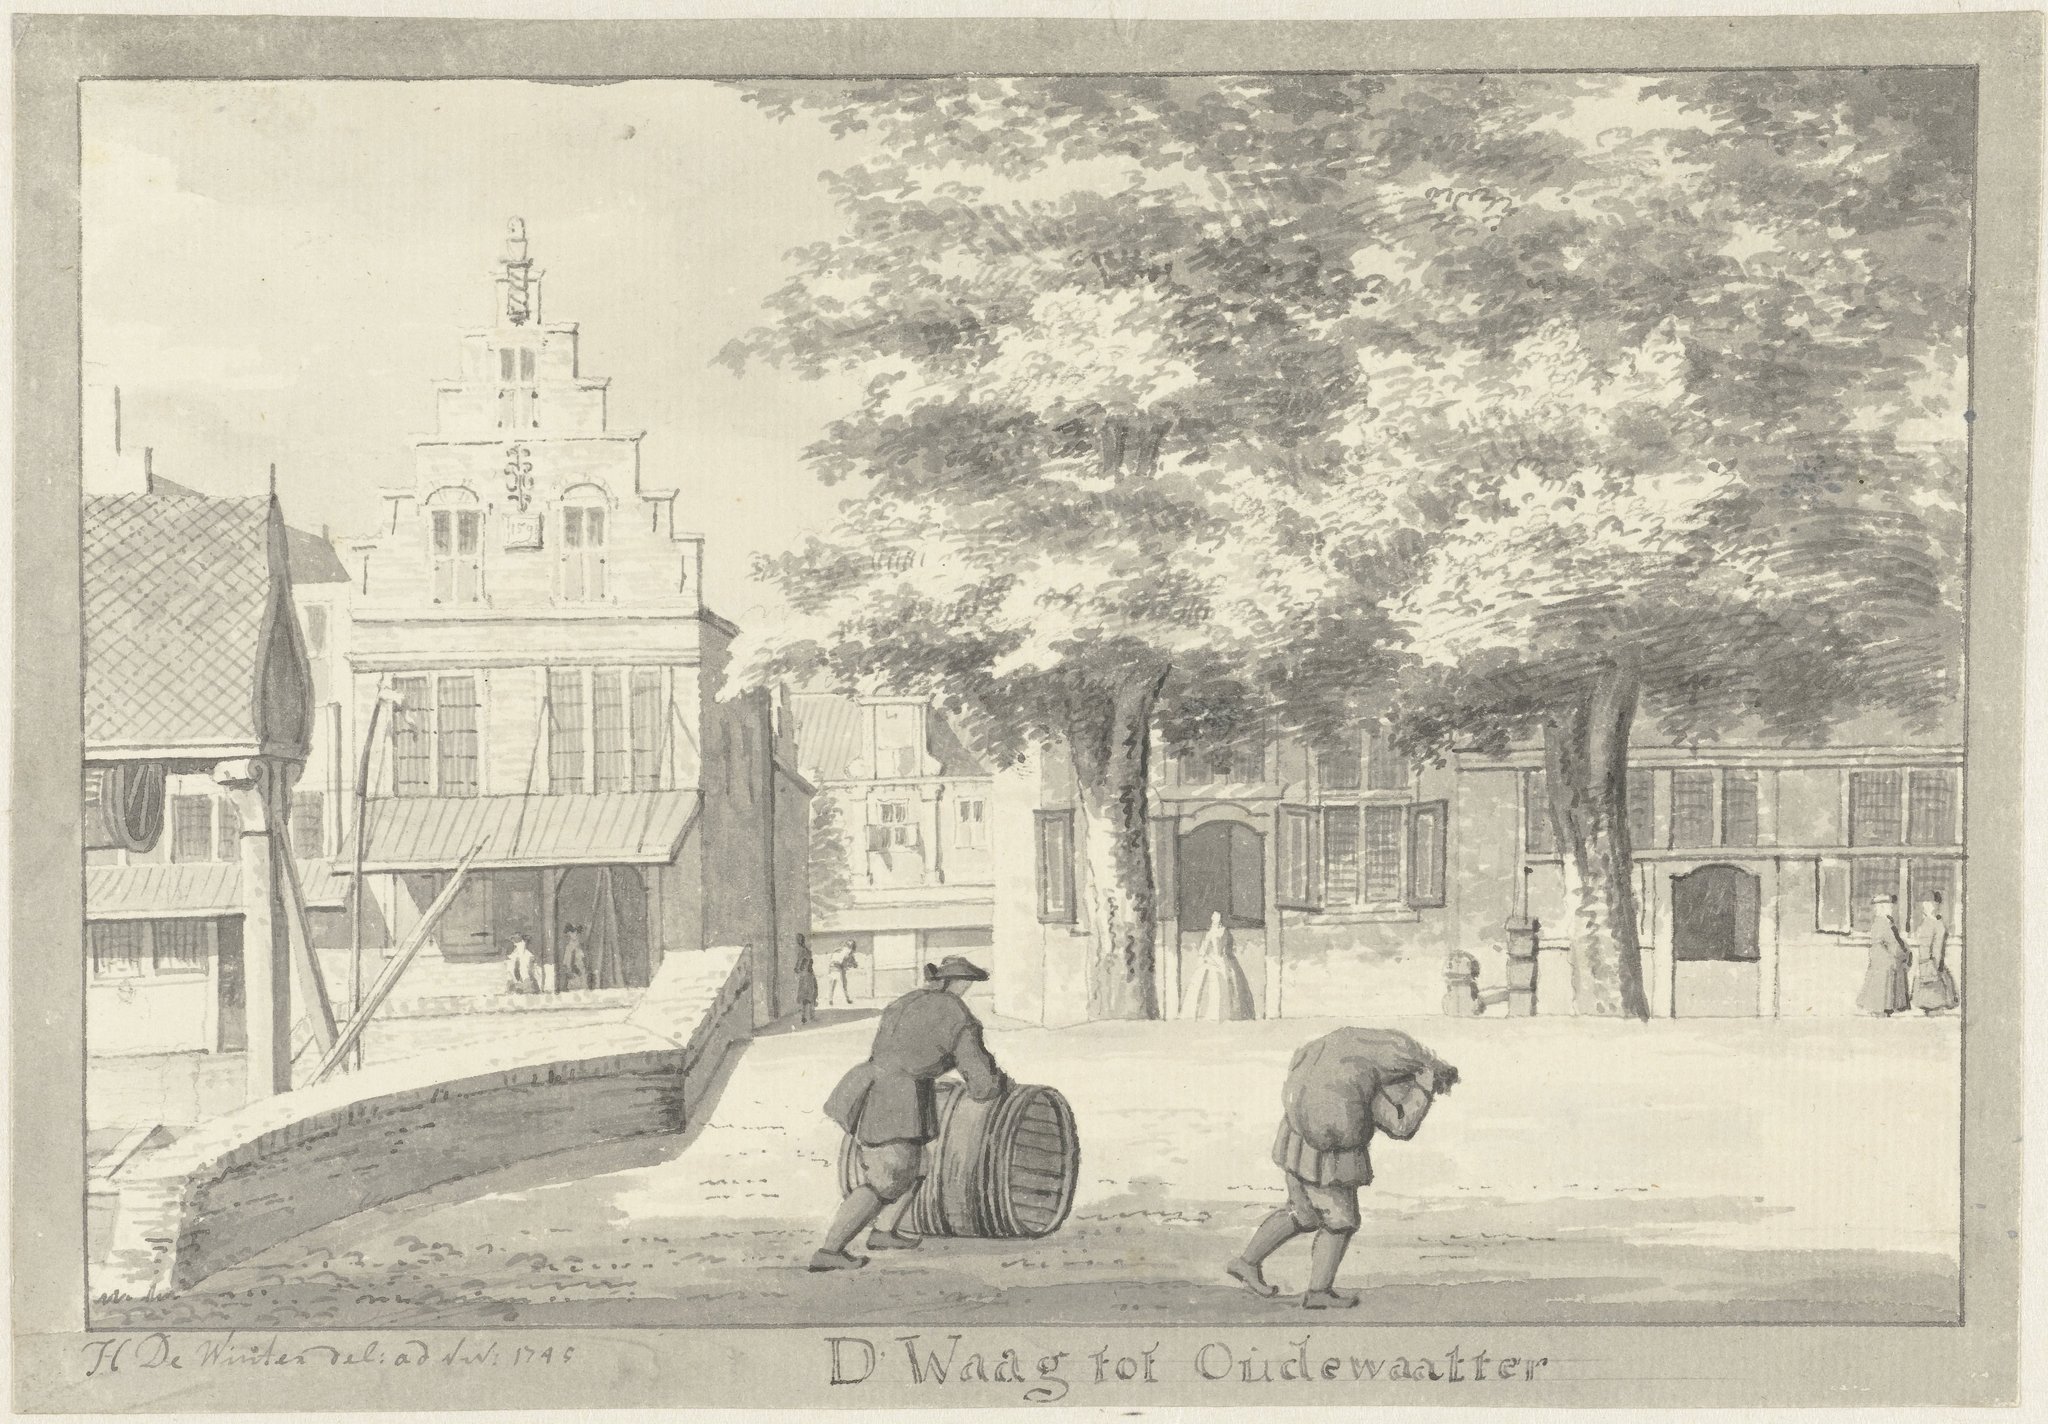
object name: drawing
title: De Waag te Oudewater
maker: hendrik de winter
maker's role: draughtsman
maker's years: 1717-1790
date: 1745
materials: ink, paper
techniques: brush, pen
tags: street, weigh-house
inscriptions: inscription: ‘H De Winter del: ad viv: 1745 D'Waag tot Oudewaatter’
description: Voor prent gebaseerd op deze tekening zie RP-P-AO-10-65A-4.